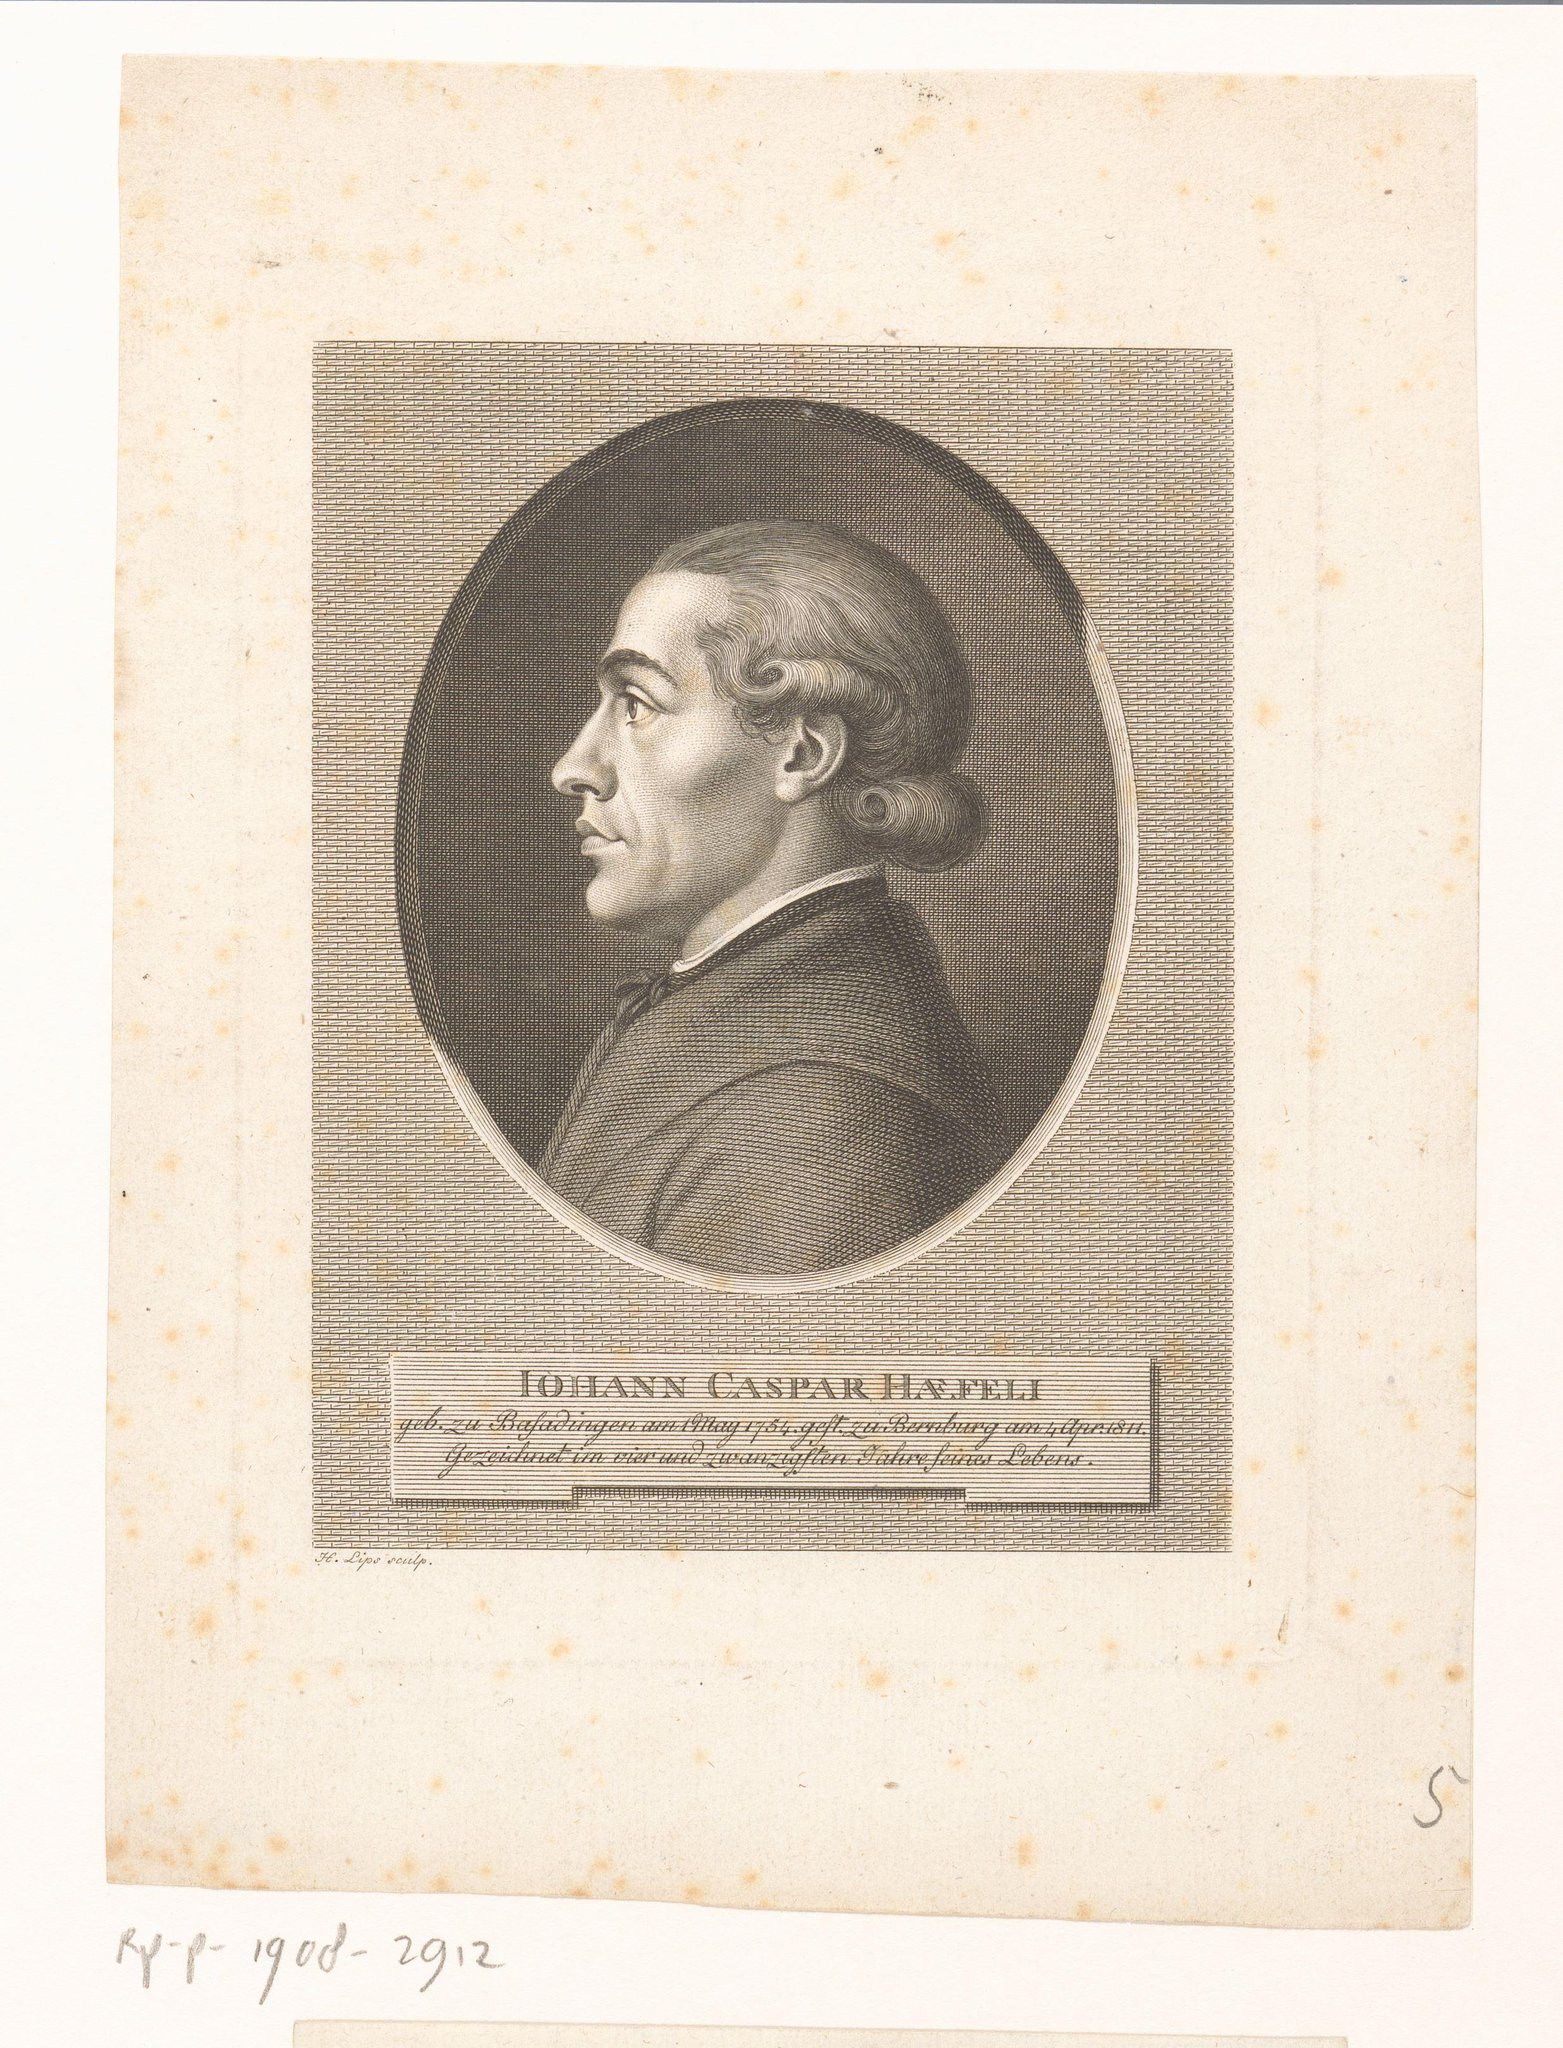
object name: print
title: Portret van Johann Caspar Haefeli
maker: johann heinrich lips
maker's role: draughtsman, painter, print maker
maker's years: 1758-1817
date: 1811-1817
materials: paper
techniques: engraving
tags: theologian, historical persons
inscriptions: collector's mark: Lugt 2228